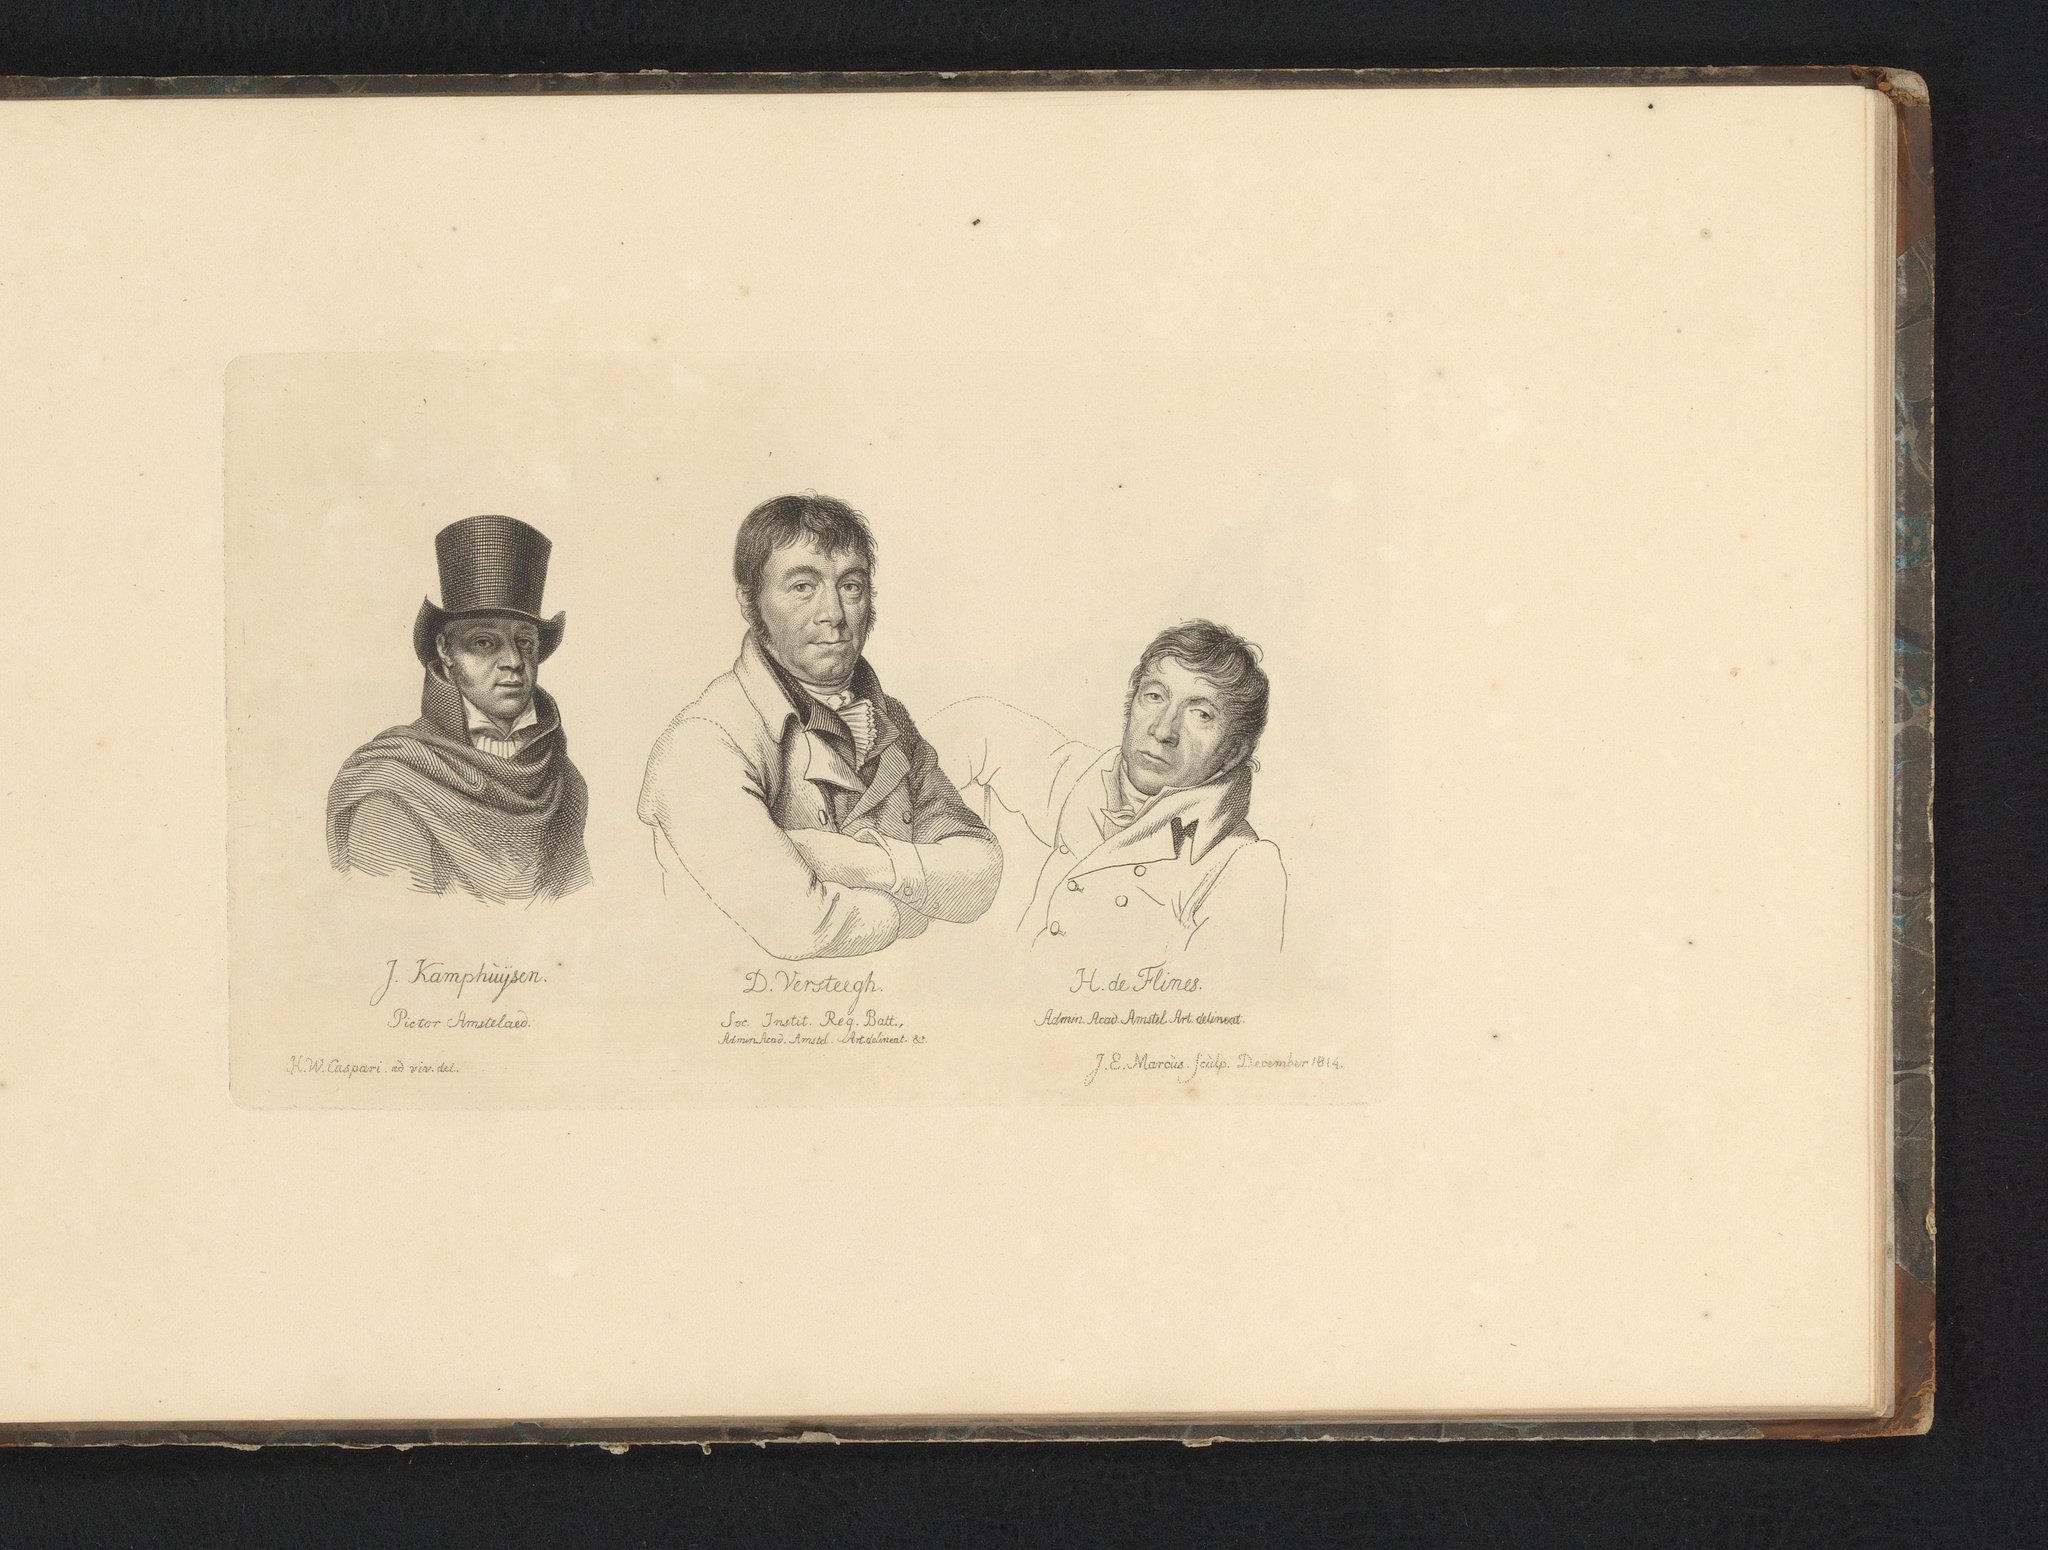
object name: print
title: Studiebeelden en fragmenten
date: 1812-1814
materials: paper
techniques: etching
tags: amsterdam, painter, draughtsman, jan kamphuijsen, dirk versteegh, hendrik de flines, historical persons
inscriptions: date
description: Deze prent maakt deel uit van een album.